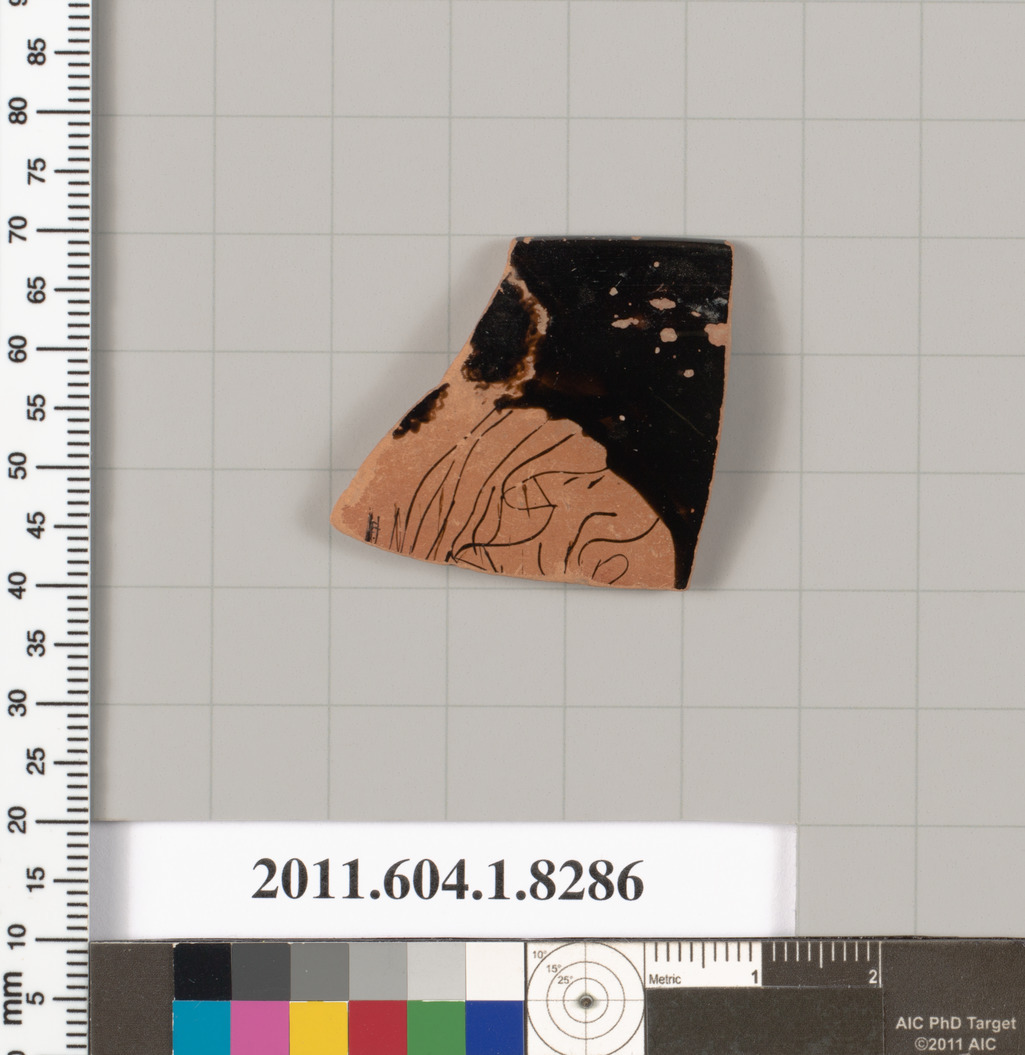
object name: kylix fragment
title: Terracotta rim fragment of a kylix (drinking cup)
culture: greek, attic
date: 425-401 BCE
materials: terracotta